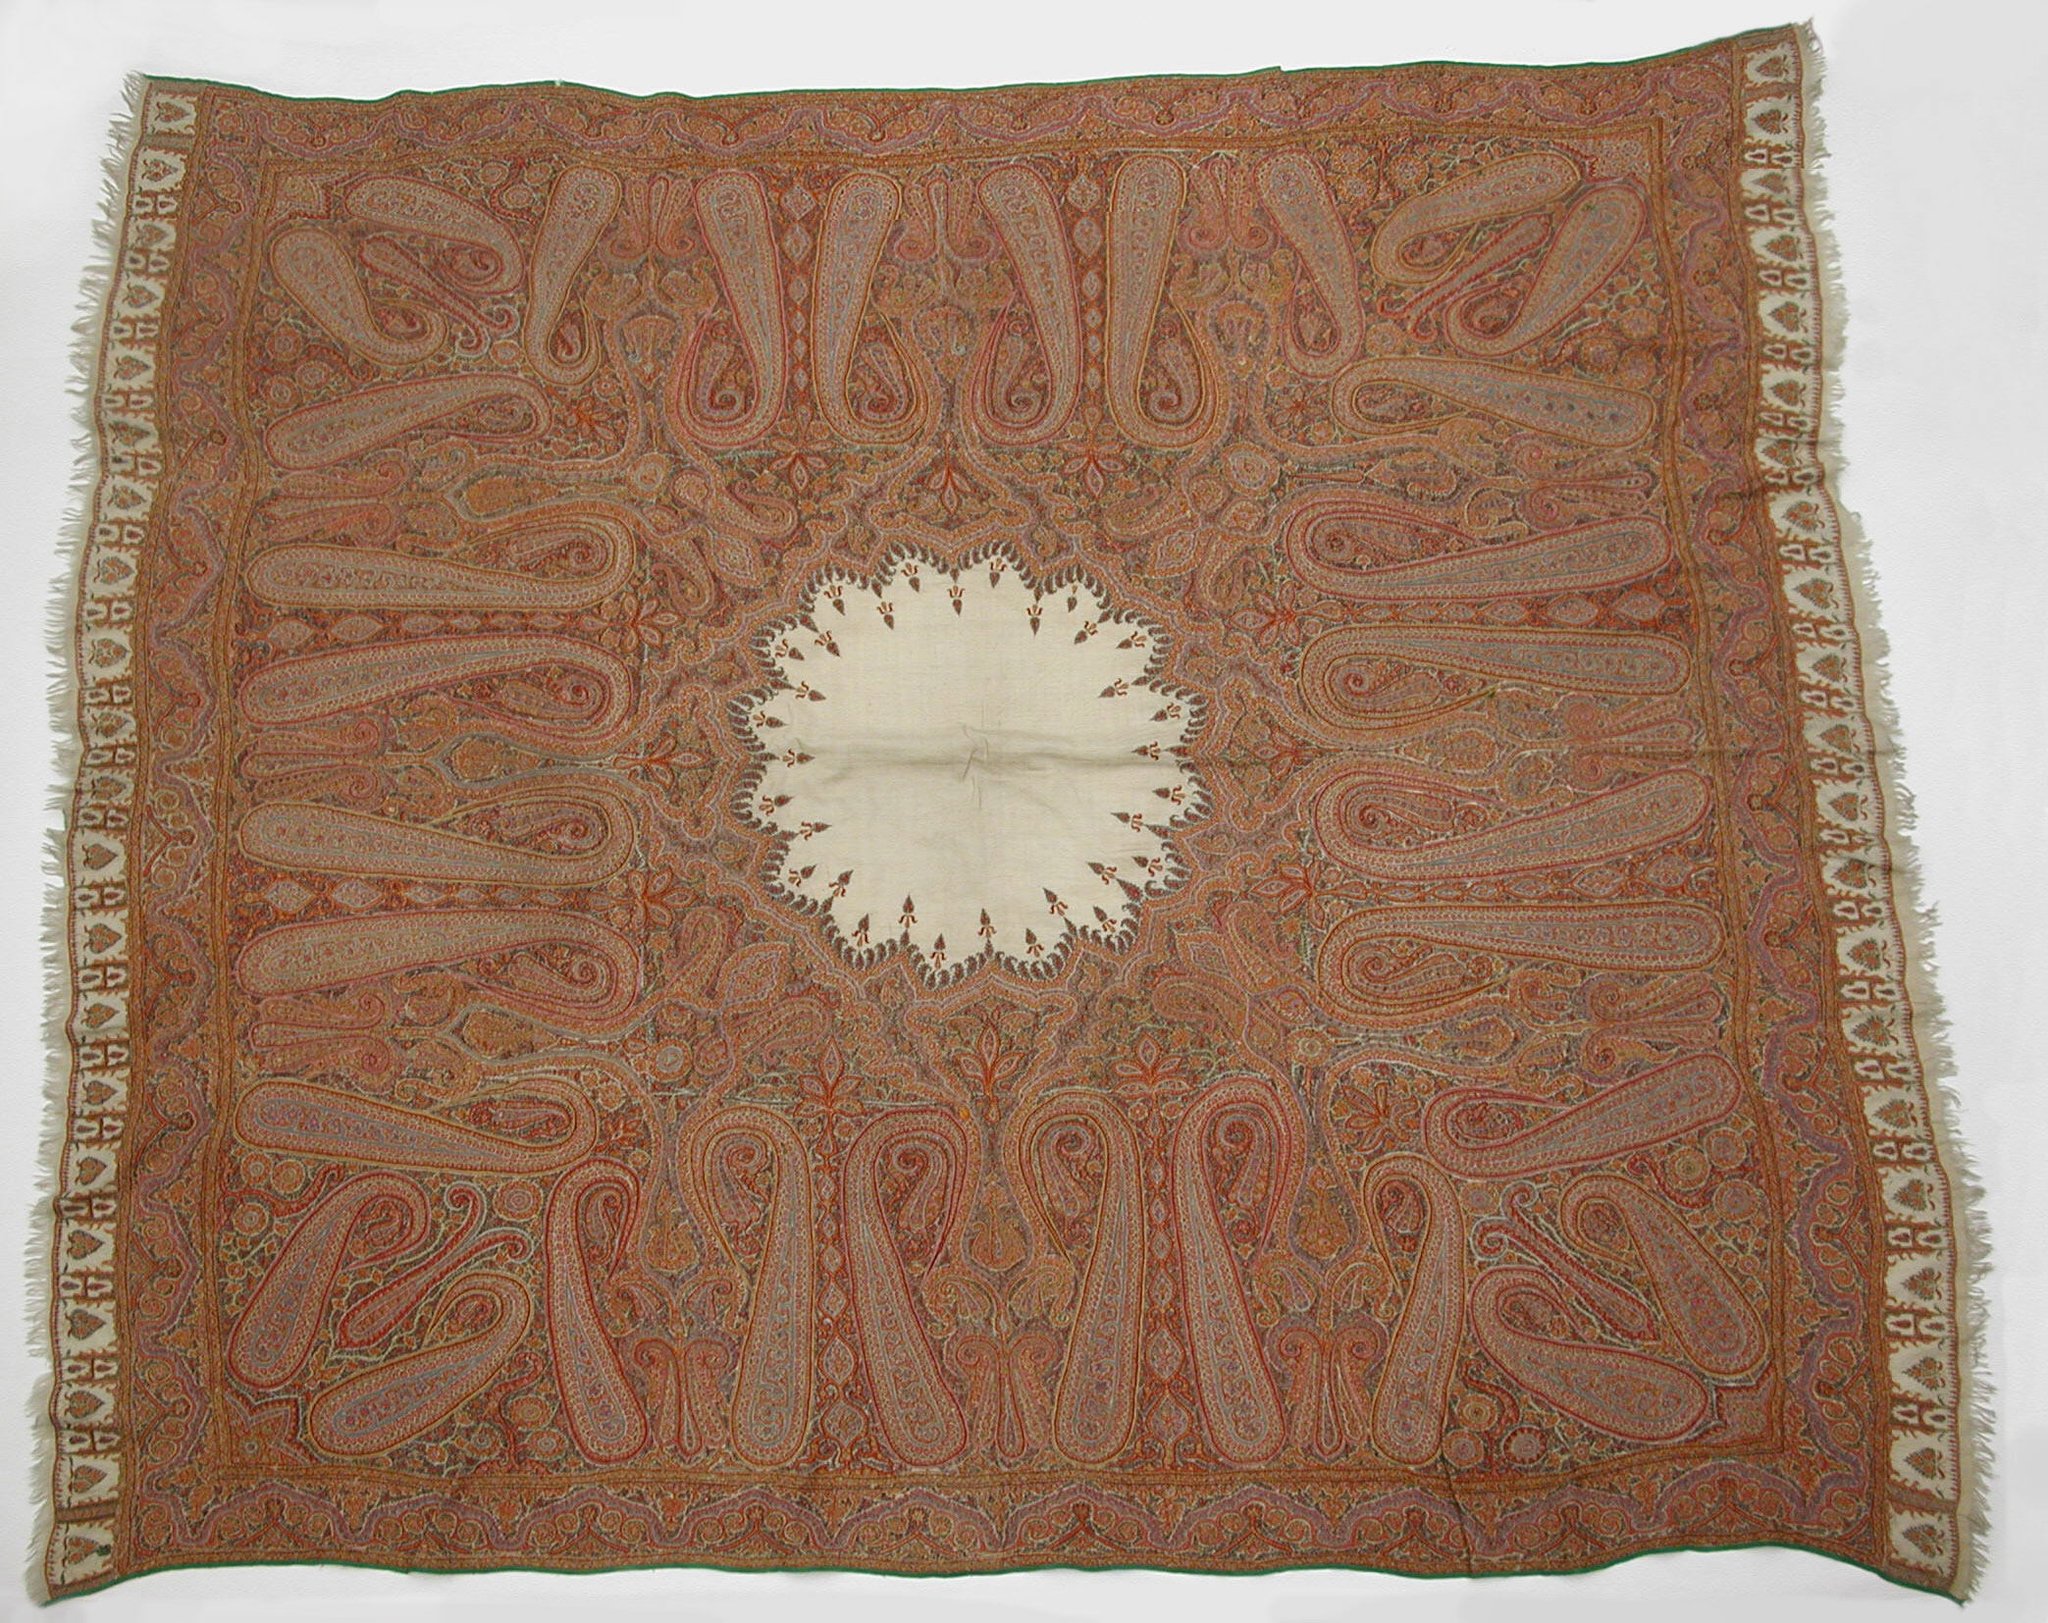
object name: shawl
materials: wool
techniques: embroidery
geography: india